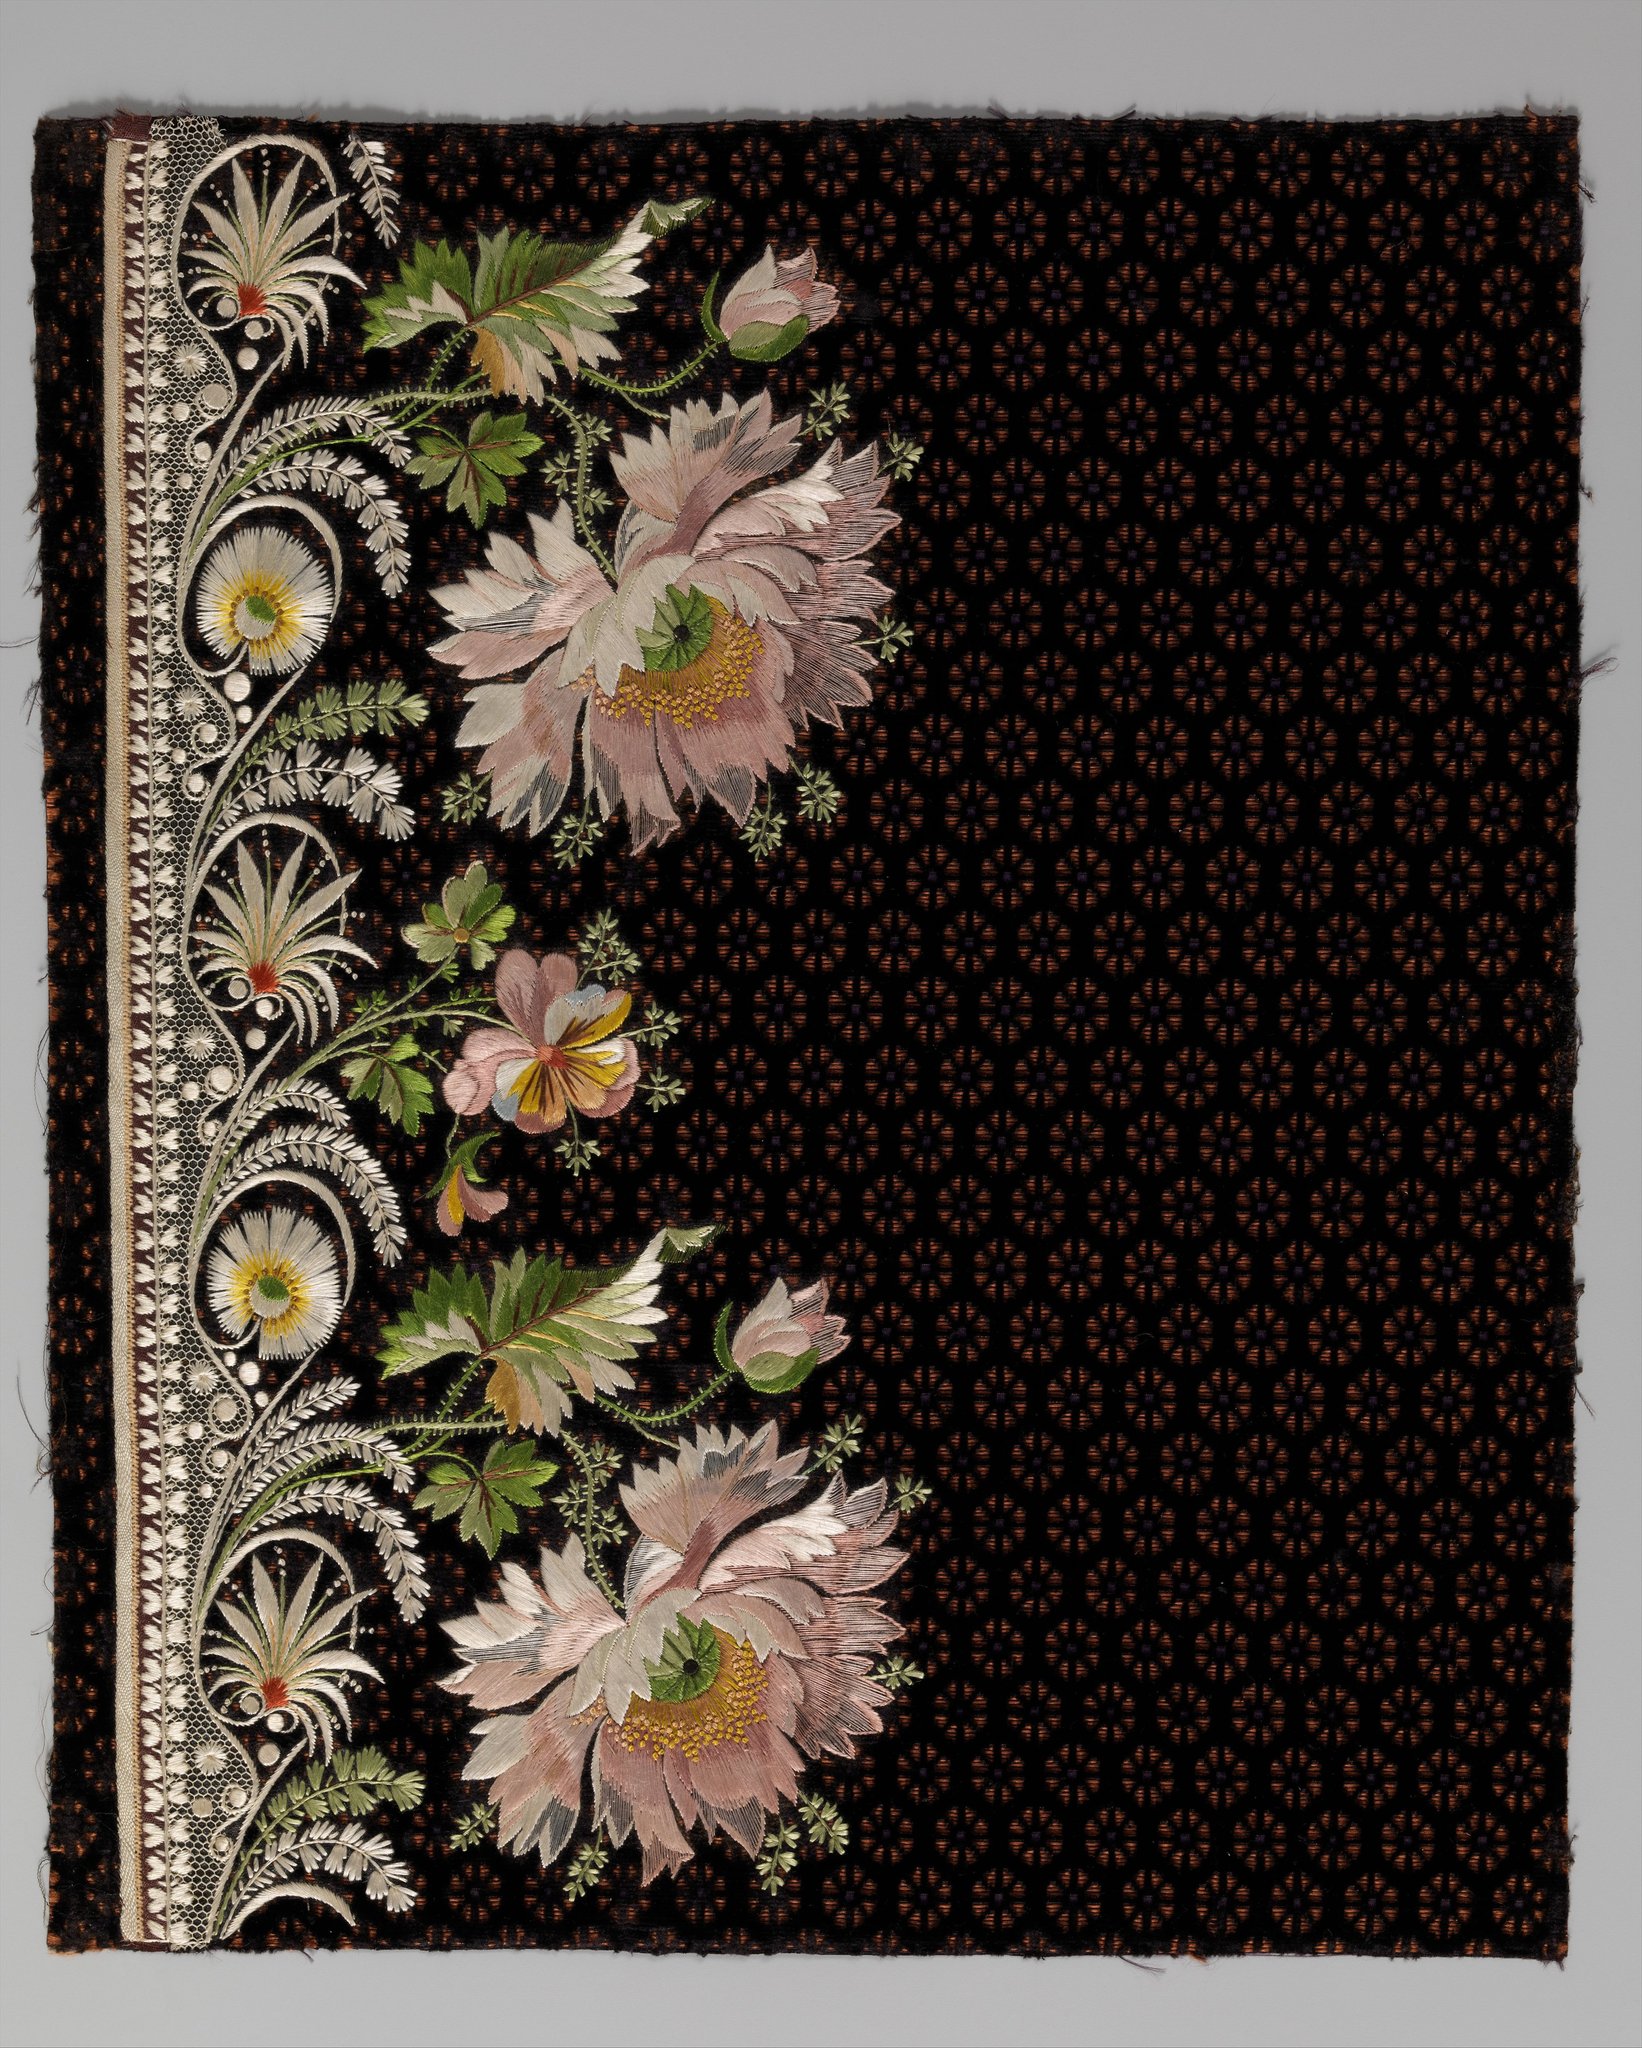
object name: sample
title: Embroidery sample for a man’s suit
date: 1800-1815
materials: silk, velvet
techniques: embroidery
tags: flowers